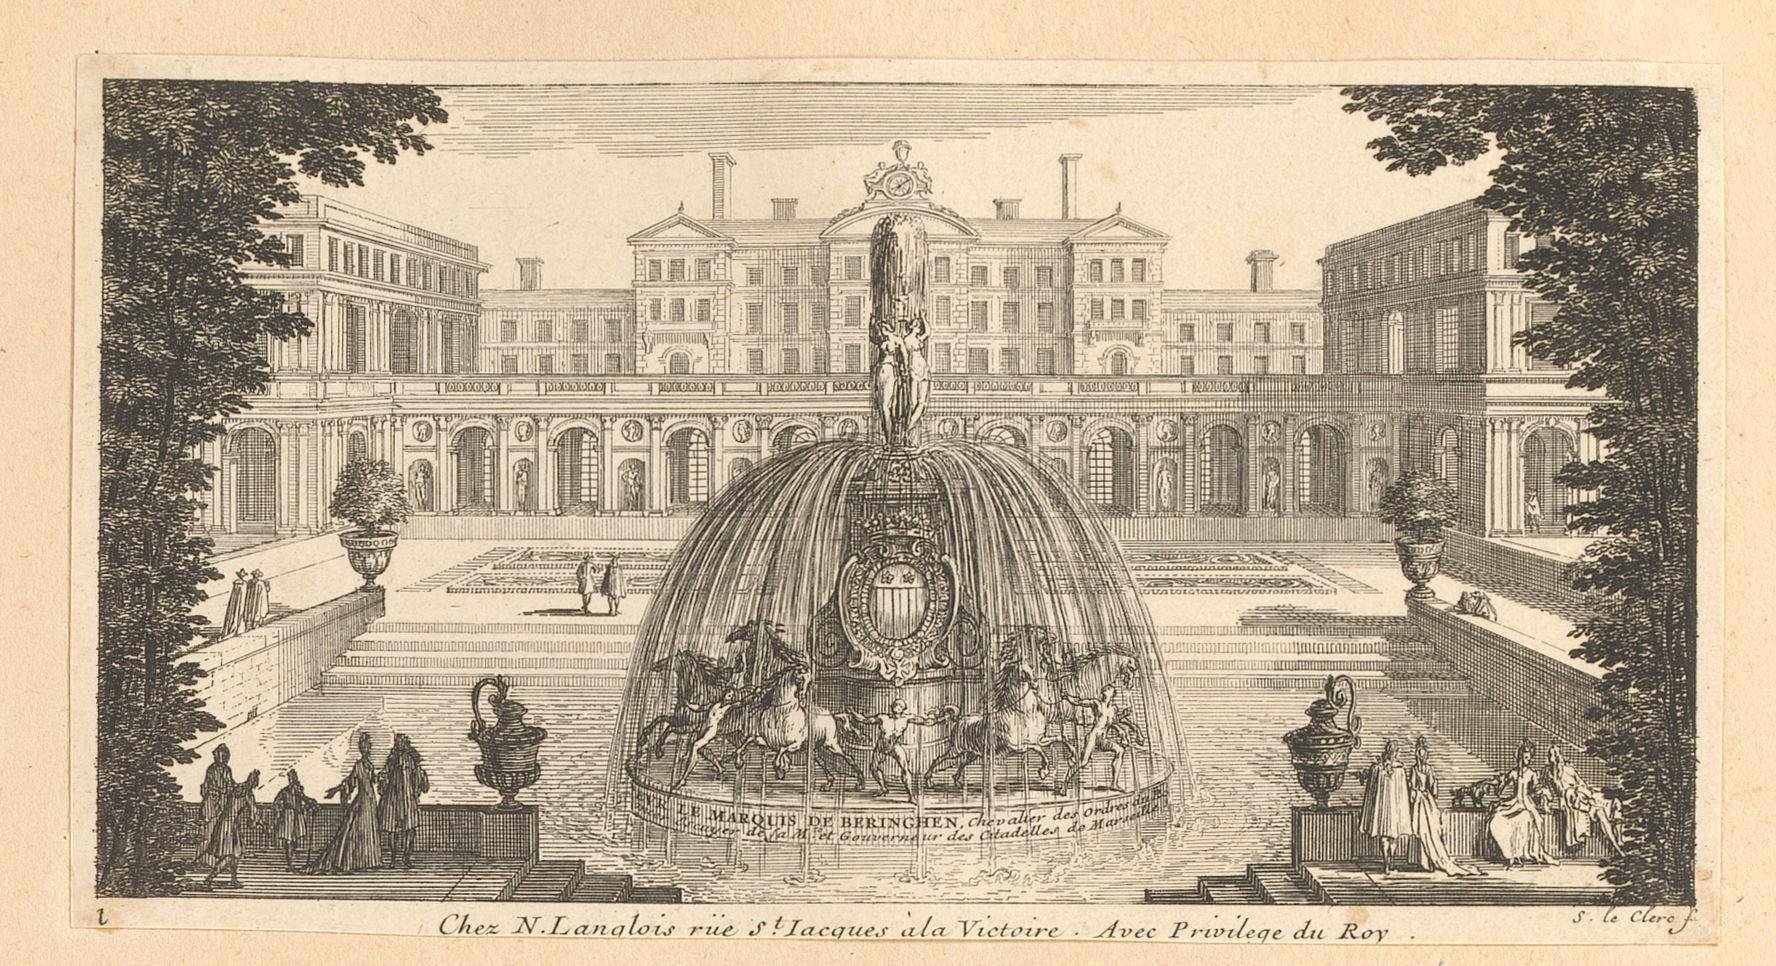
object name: titelprent, frontispice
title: Livre de paysage dédié à Monsieur de Beringhen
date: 1693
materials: paper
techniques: etching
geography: france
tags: paris, jacques-louis de beringhen, garden fountain, civic architecture; edifices; dwellings, armorial bearing, heraldry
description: Titelprent van een twaalfdelige serie met landschappen en gezichten op verschillende gebouwen. Een eerste editie werd uitgegeven door Nicolas Langlois in 1693 en een tweede in 1784 door Lamy.